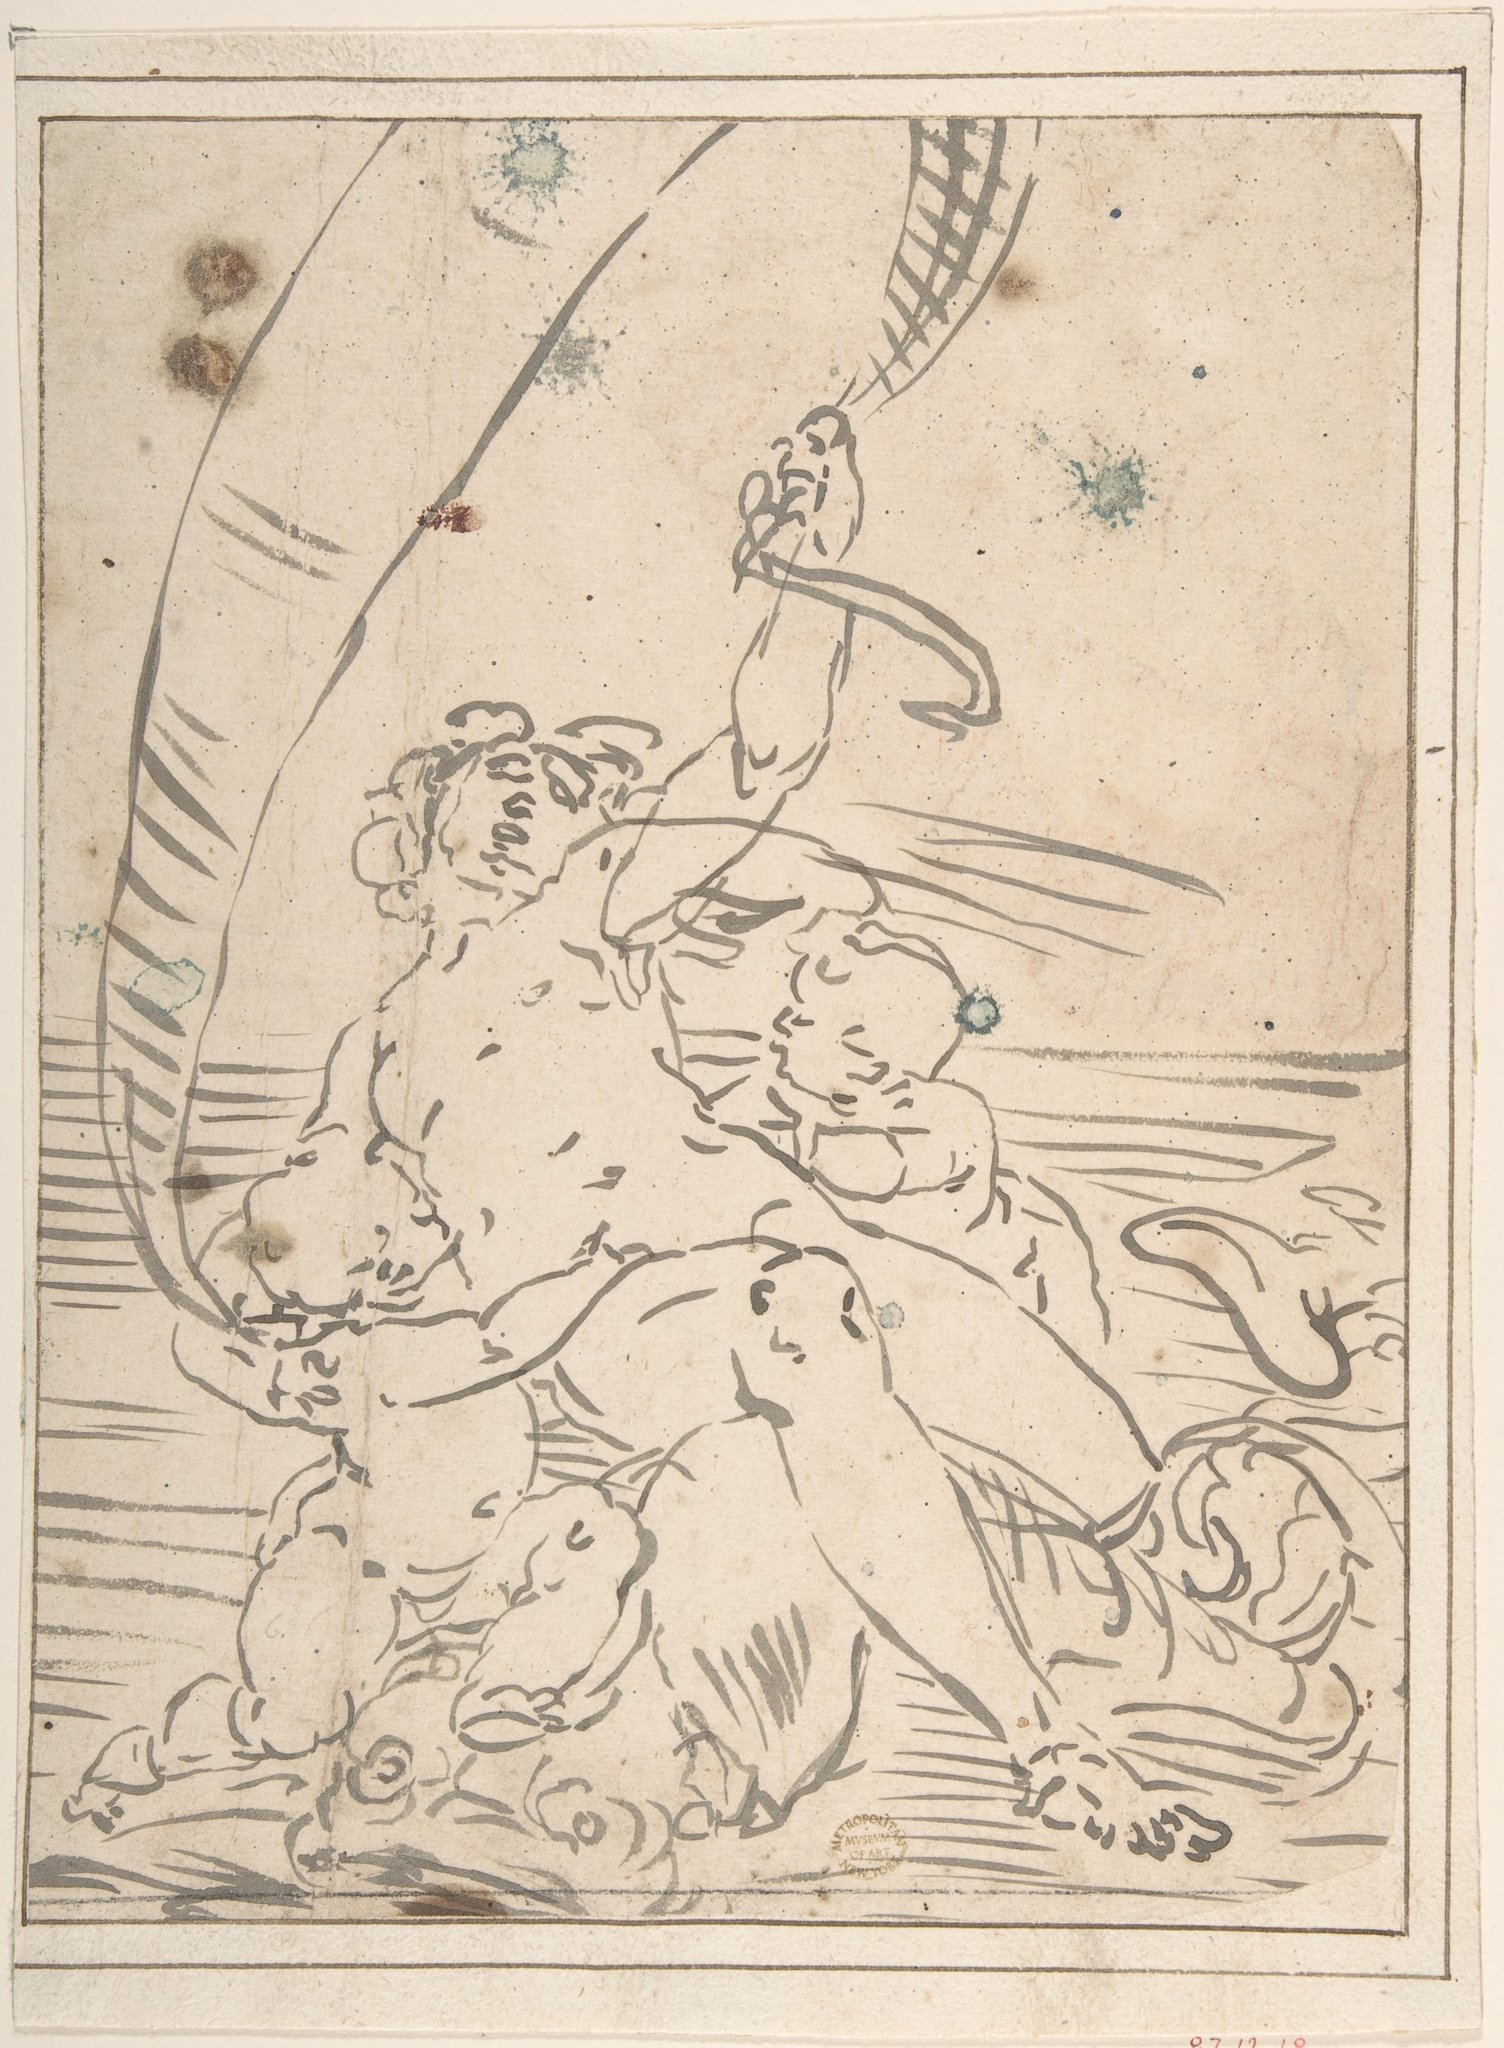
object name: drawing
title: Arion and Two Cupids on a Dolphin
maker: luca cambiaso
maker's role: artist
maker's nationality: italian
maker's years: 1527-1585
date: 1527-1585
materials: ink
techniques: brush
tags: cupid,dolphins